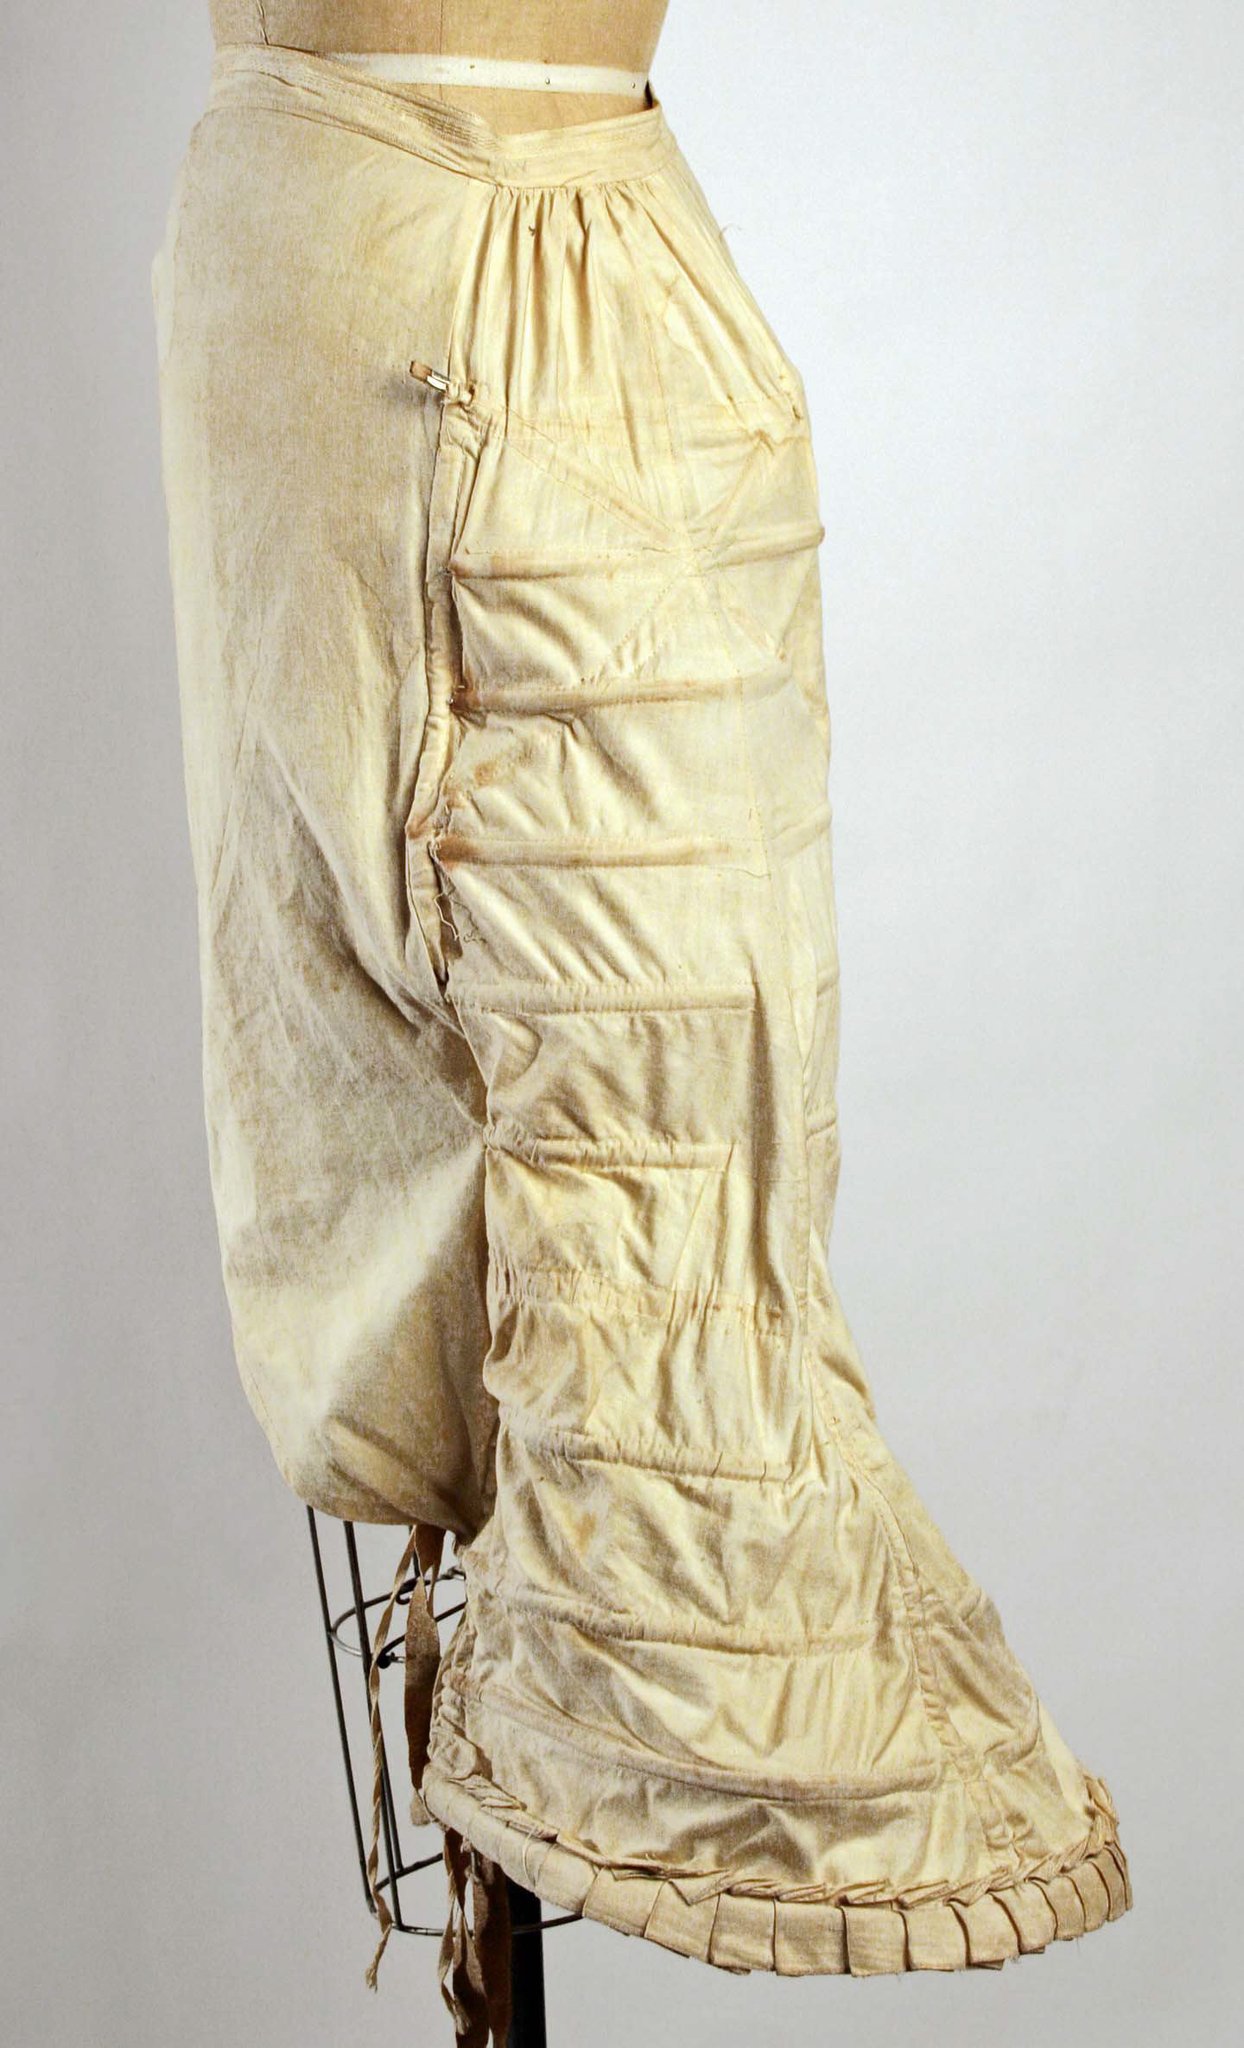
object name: bustle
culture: american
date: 1870-1879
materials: cotton